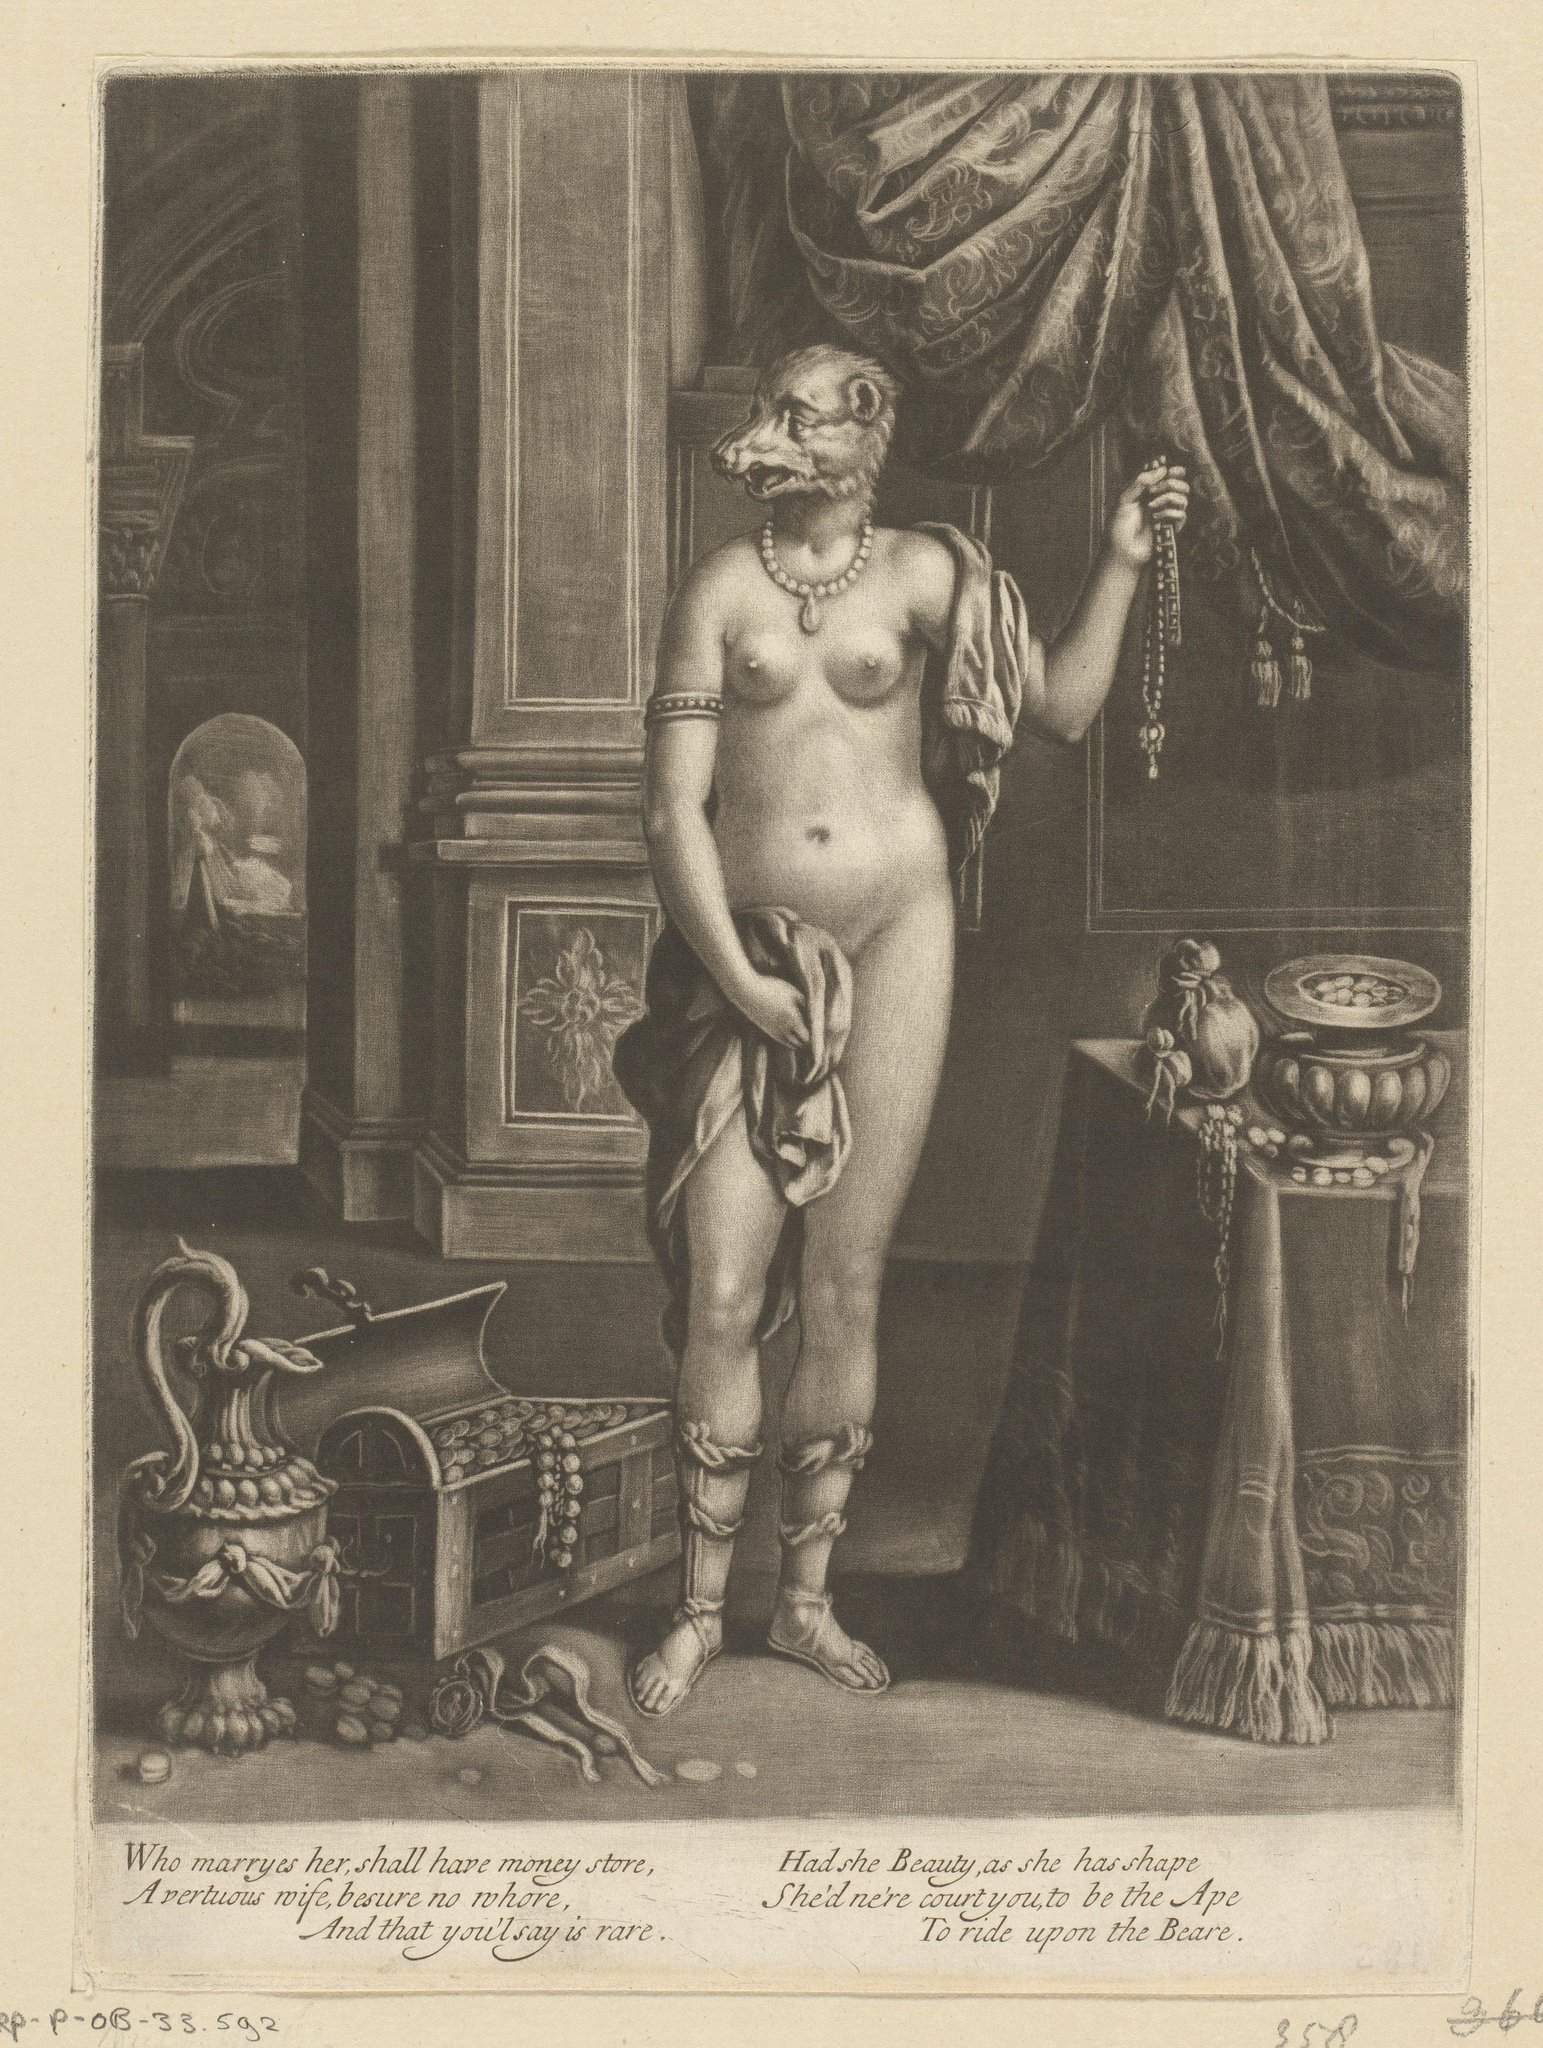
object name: print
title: Naakte vrouw met kop van een beer en juwelen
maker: Anonymous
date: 1680-1700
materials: paper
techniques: mezzotint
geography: england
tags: monsters with animal head - aa - female human figure, ornaments, jewels, beasts of prey, predatory animals: bear, coin, nude with covered genitals - aa - female human figure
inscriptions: collector's mark: Lugt 240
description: Zie ook het vers 'The Bear Fac'd Lady' in: Wesley, Samuel. Maggots, or, Poems on several subjects never before handled. Londen: John Dunton, 1685, p. 29-33.